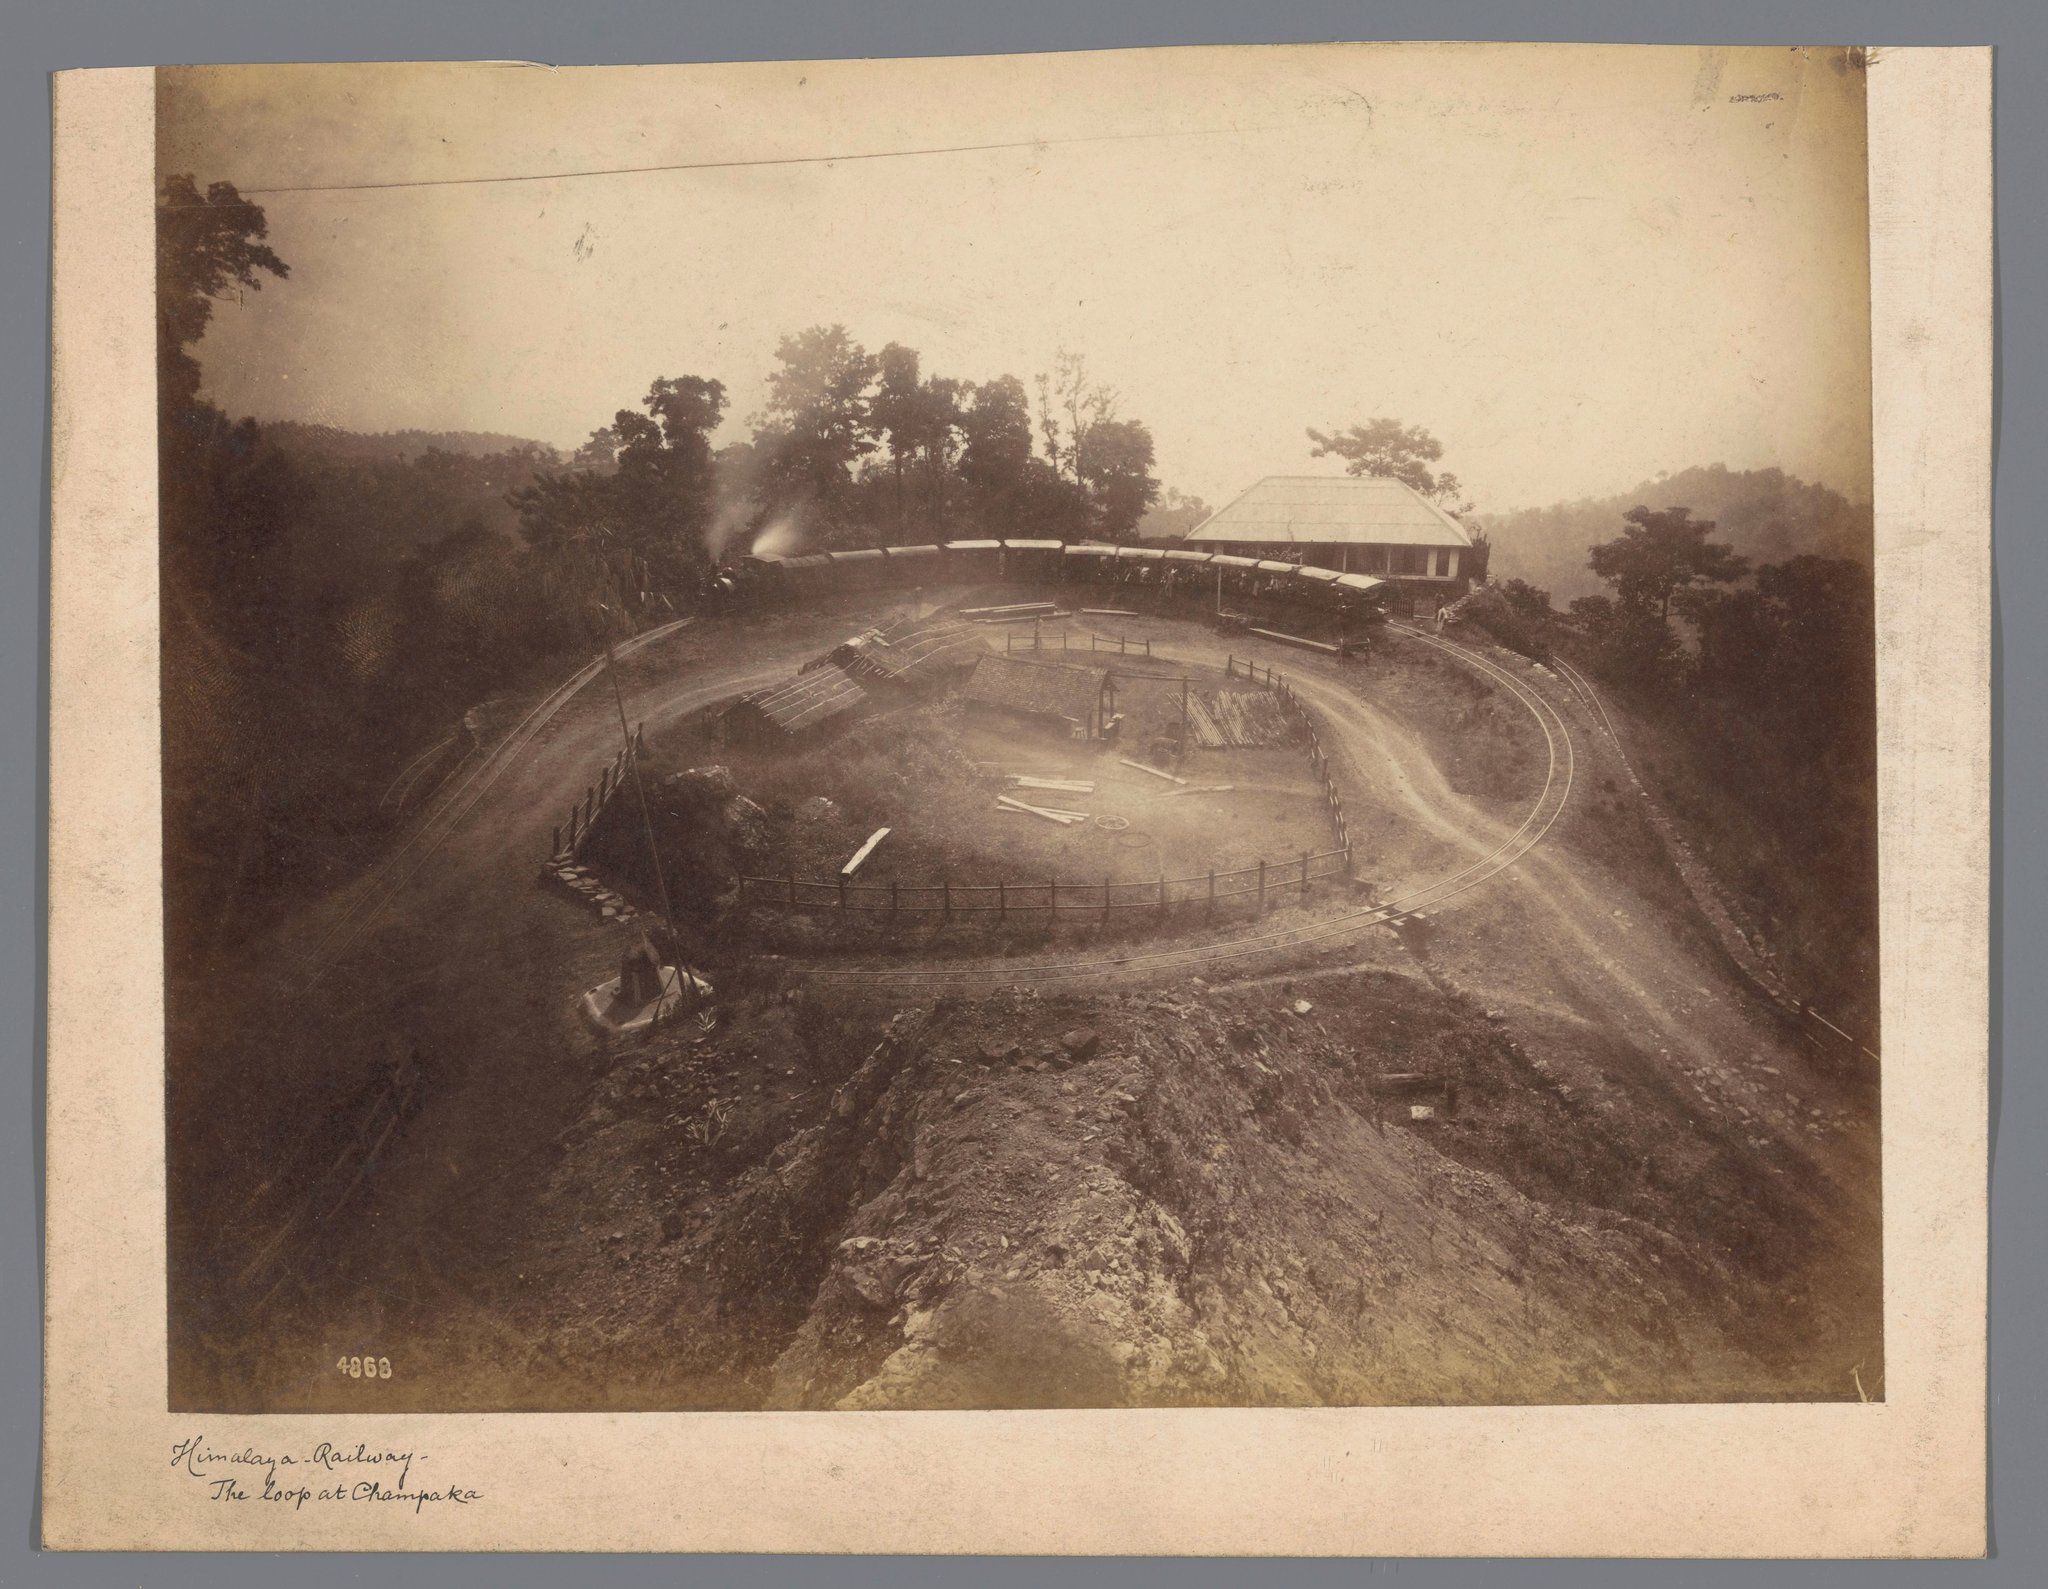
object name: photograph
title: Train at the Chunabhatti loop in the Darjeeling Himalayan Railway, West Bengal, India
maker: Anonymous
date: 1884-1890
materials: cardboard, paper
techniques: albumen print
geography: west bengal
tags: railway, train, mountains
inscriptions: title: ‘Himalaya-Railway -/ The loop at Chaampaka’, number: ‘4868’